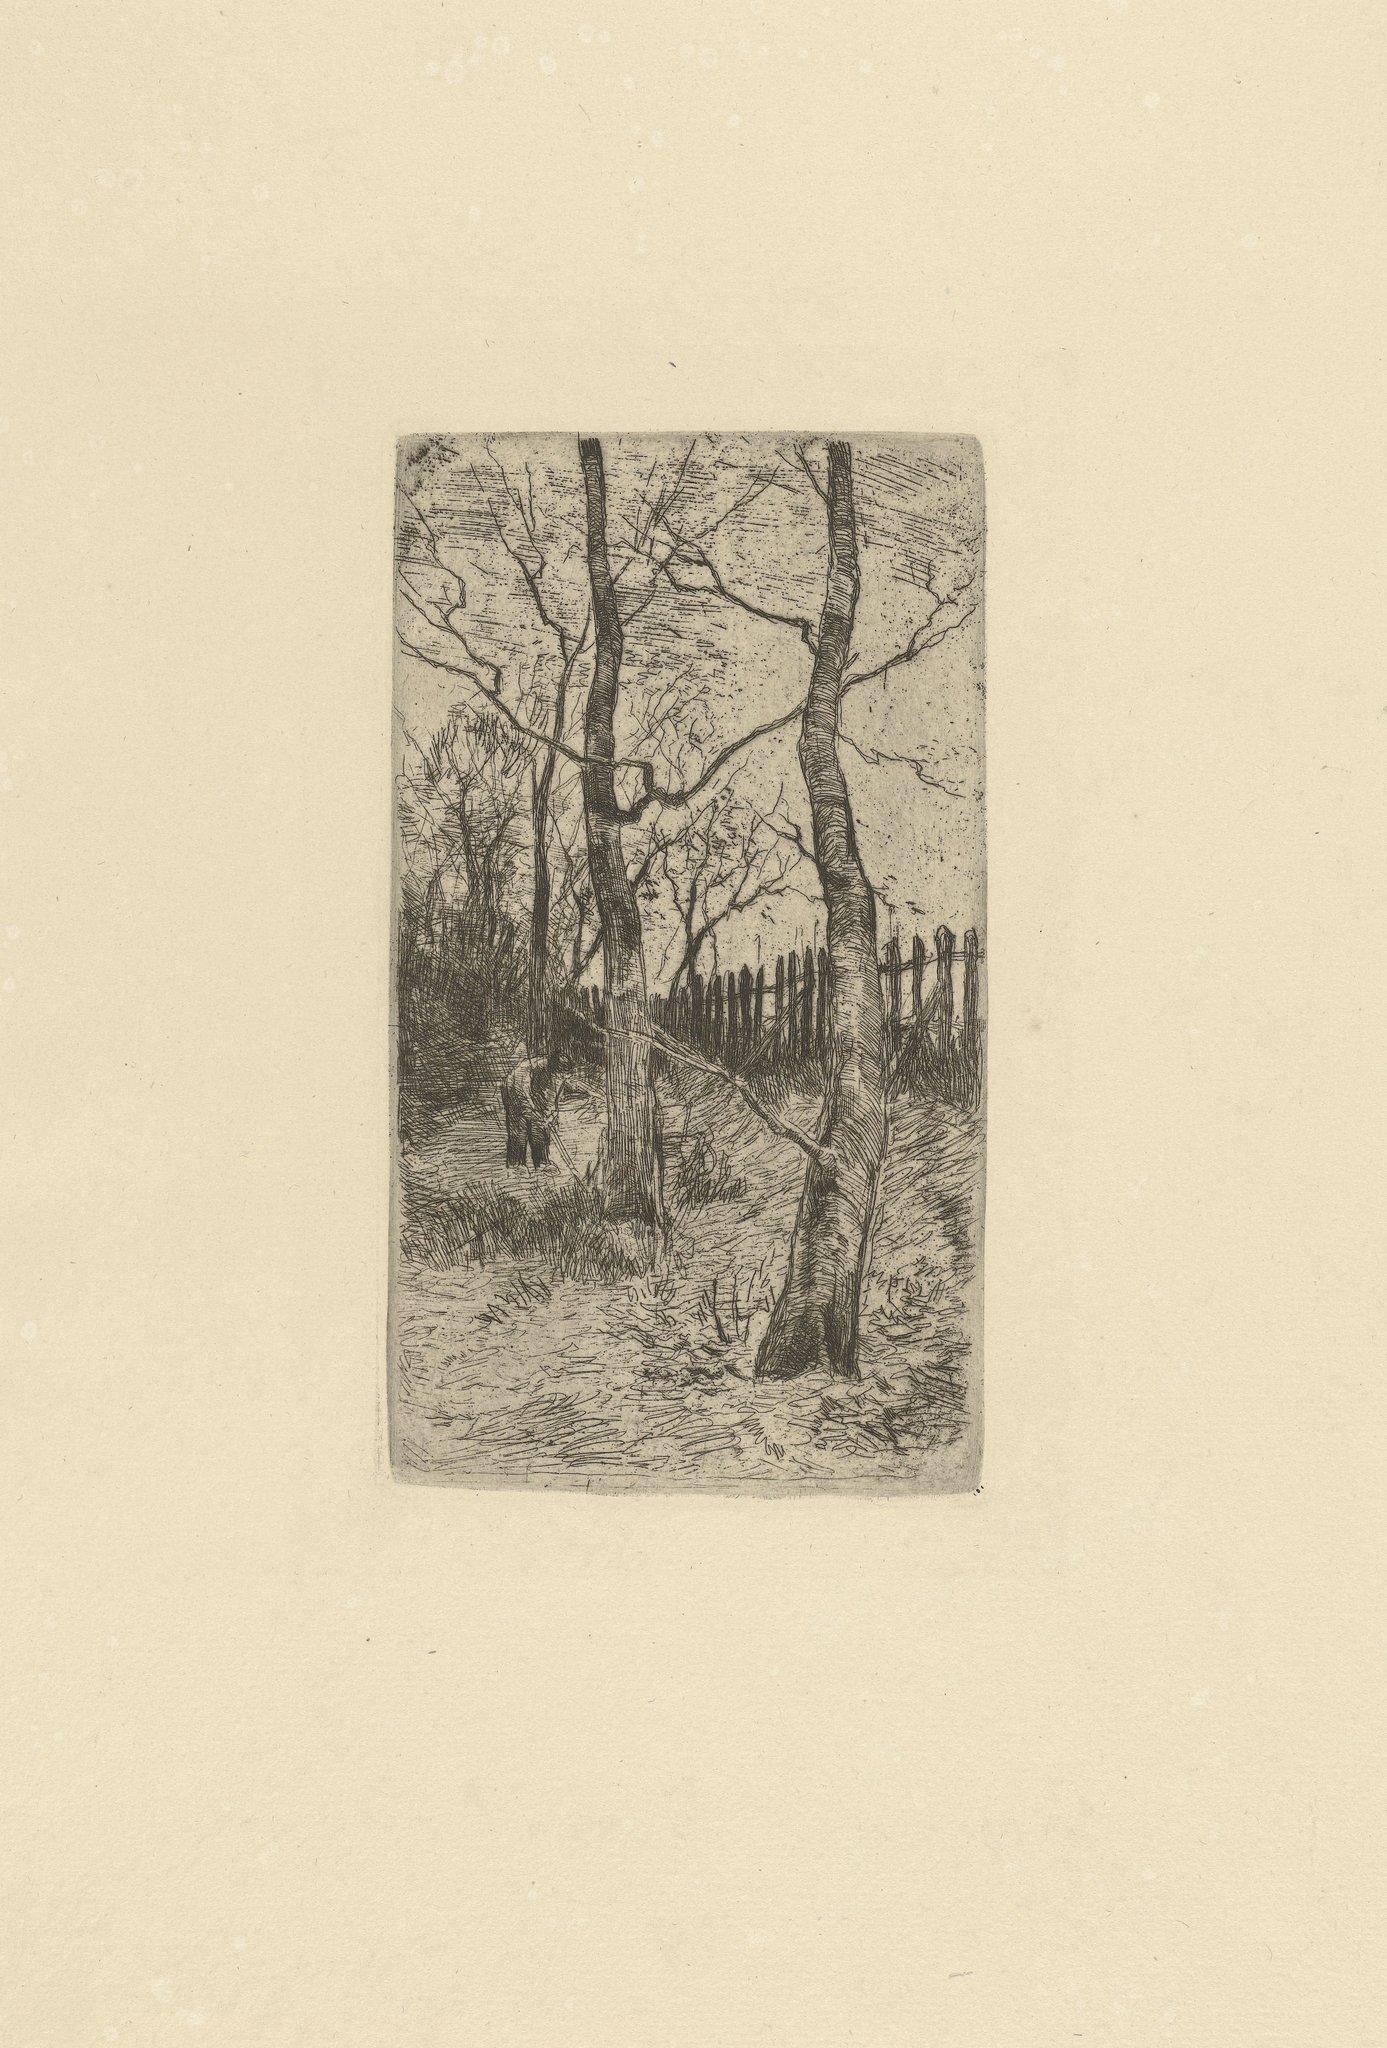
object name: print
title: Houthakker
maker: anton mauve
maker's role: draughtsman, painter, print maker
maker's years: 1838-1888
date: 1848-1888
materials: paper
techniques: etching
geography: netherlands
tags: woodcutting, woodcutter ~ forestry, fence, wall, paling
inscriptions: collector's mark: Lugt 2625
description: Twee achter elkaar staande bomen. Bij de tweede boom een voorover gebogen houthakker. Op de achtergrond kreupelhout en rechts een hek.